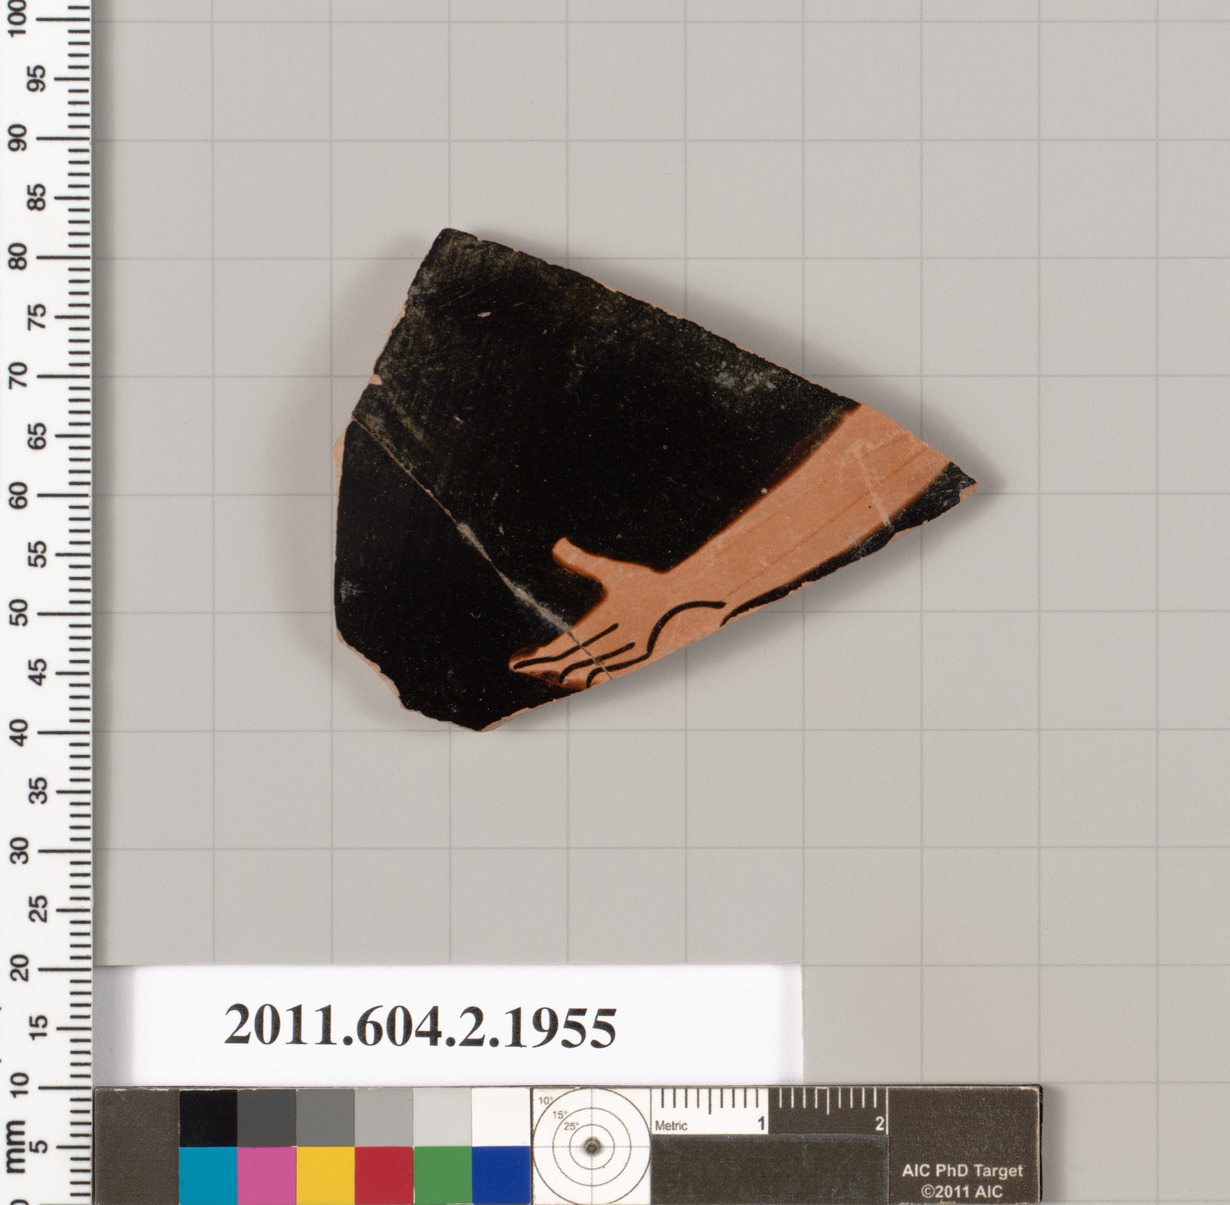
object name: neck amphora fragment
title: Terracotta fragment of a Nolan neck-amphora (jar)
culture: greek, attic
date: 480-470 BCE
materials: terracotta